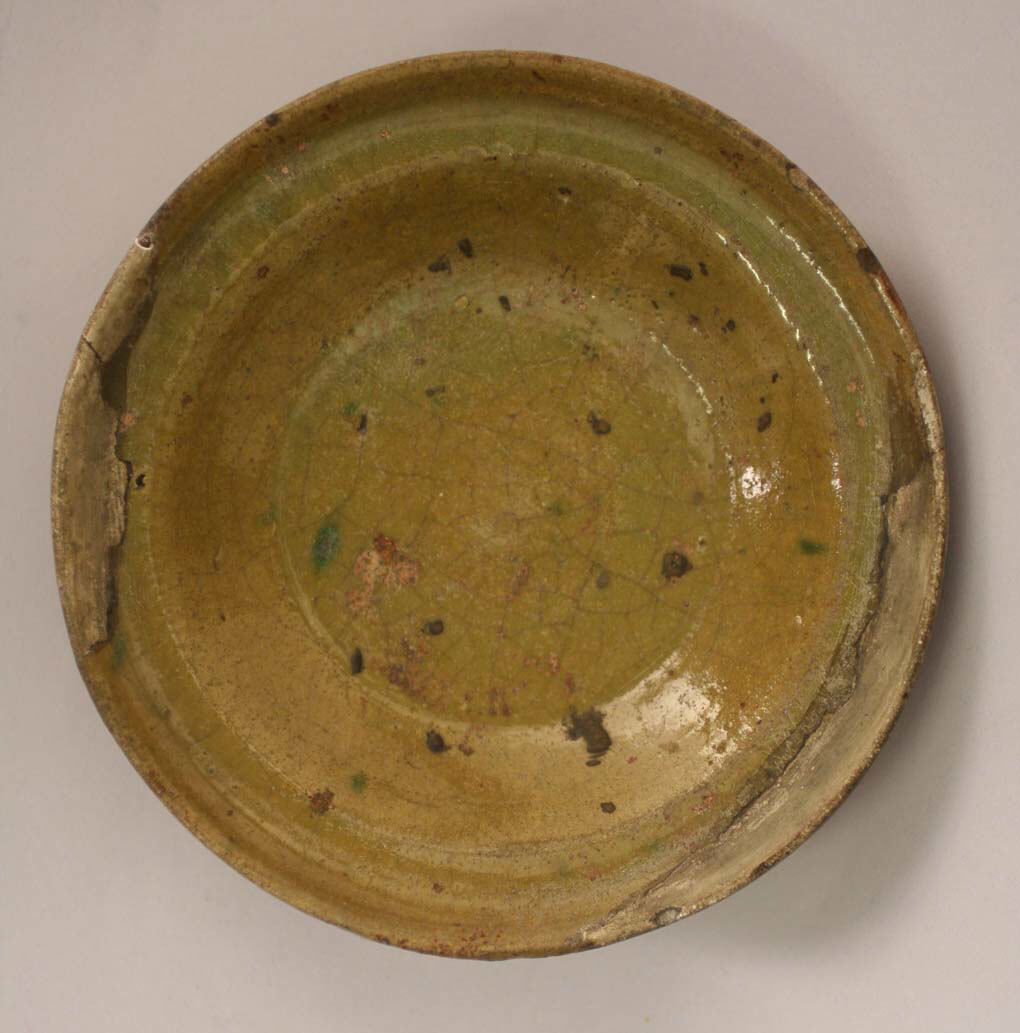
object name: bowl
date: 1301-1500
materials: earthenware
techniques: glazing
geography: egypt